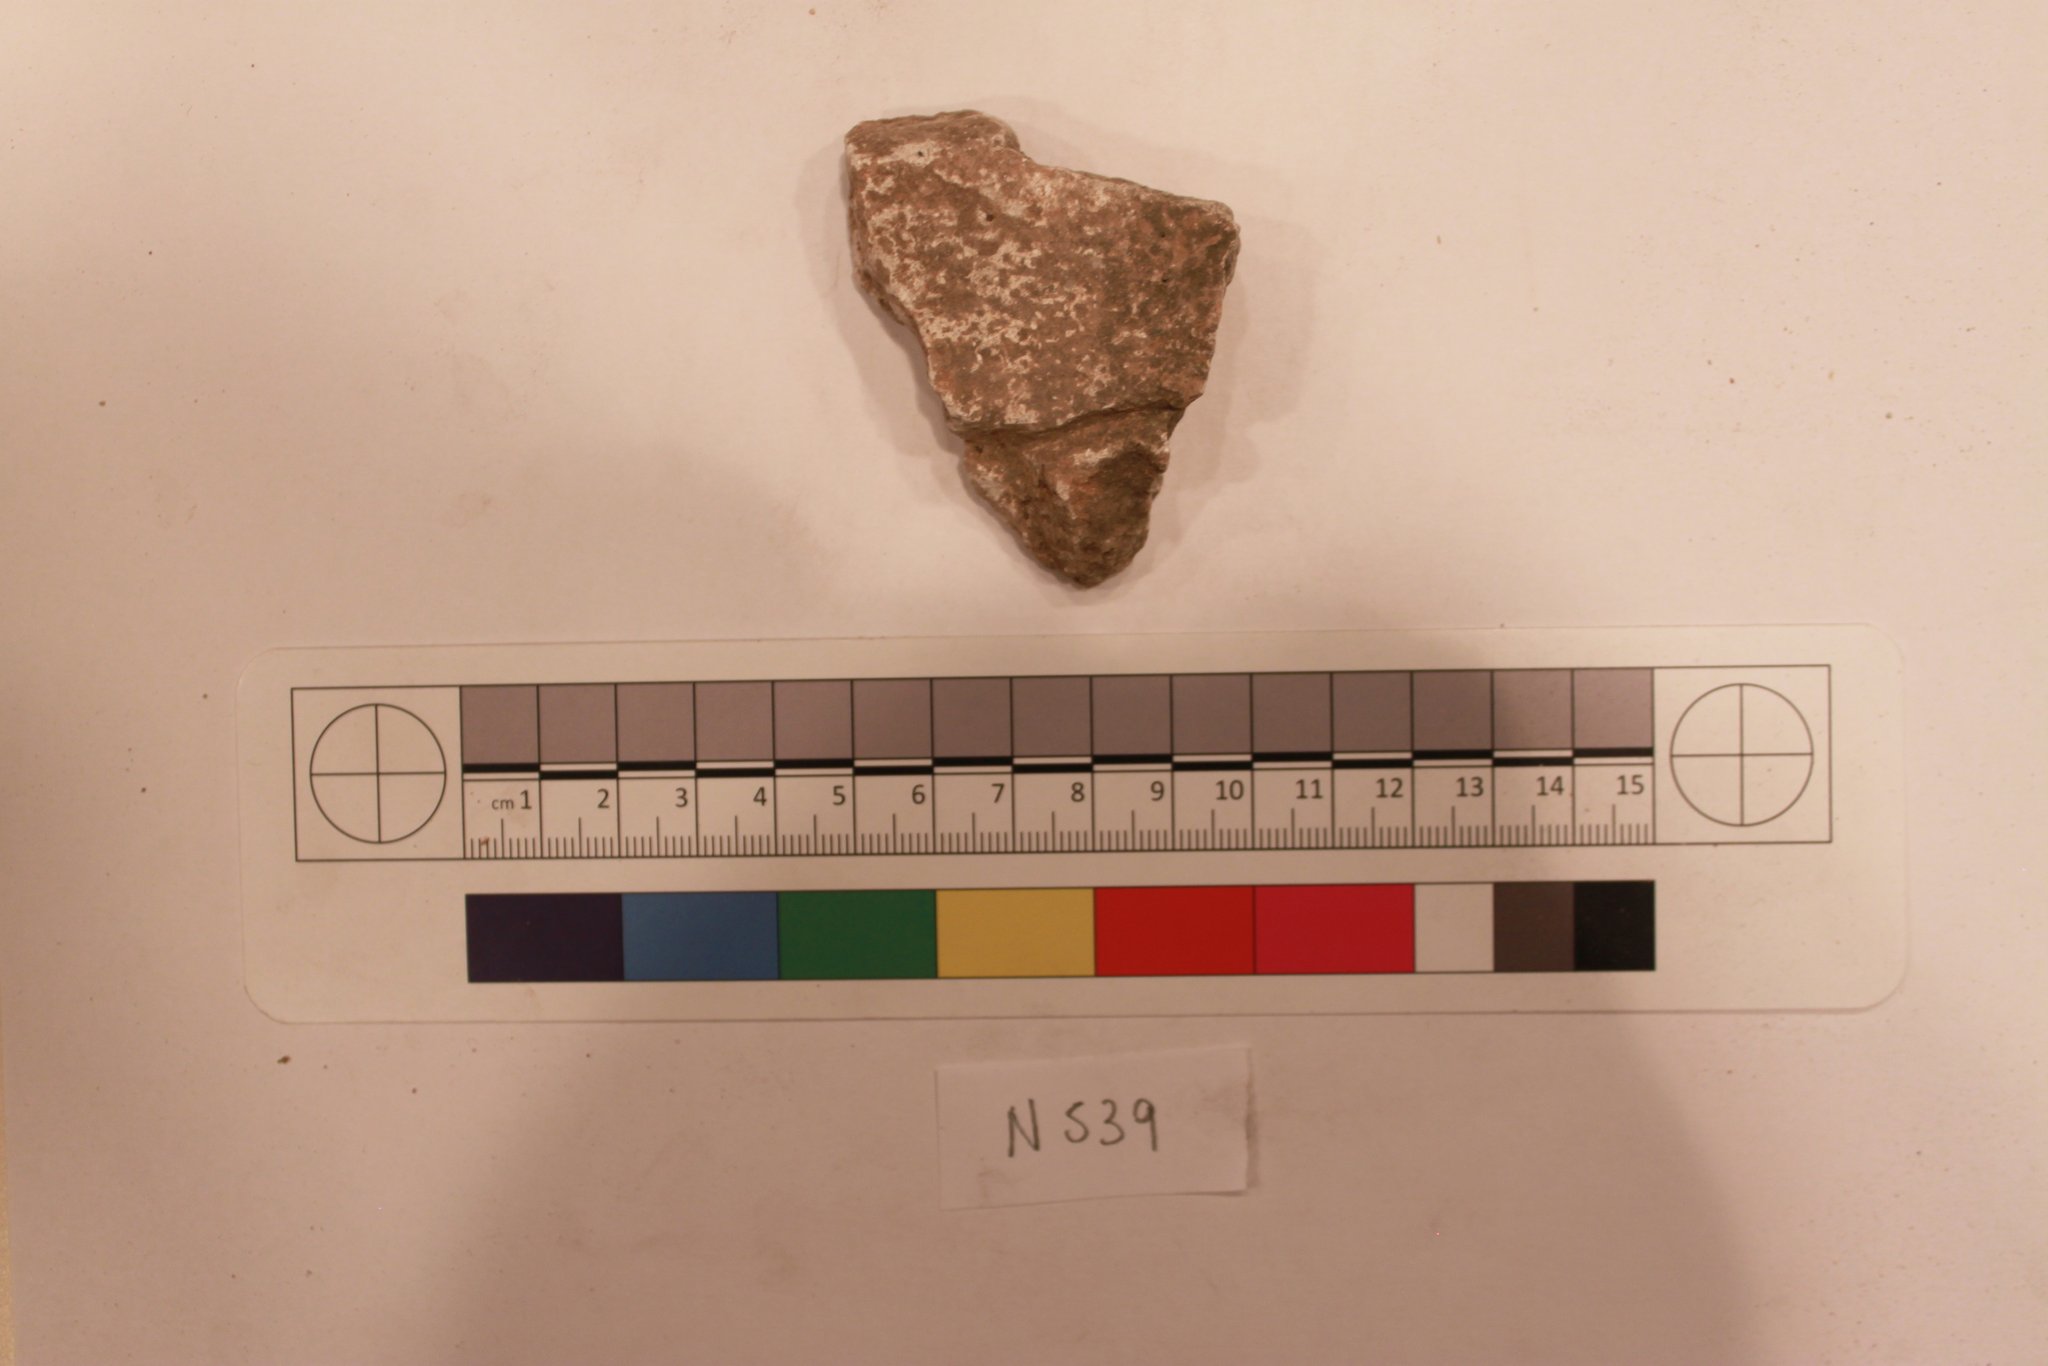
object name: fragment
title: Stucco Fragment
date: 701-1200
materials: plaster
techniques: carving, painting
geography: iran